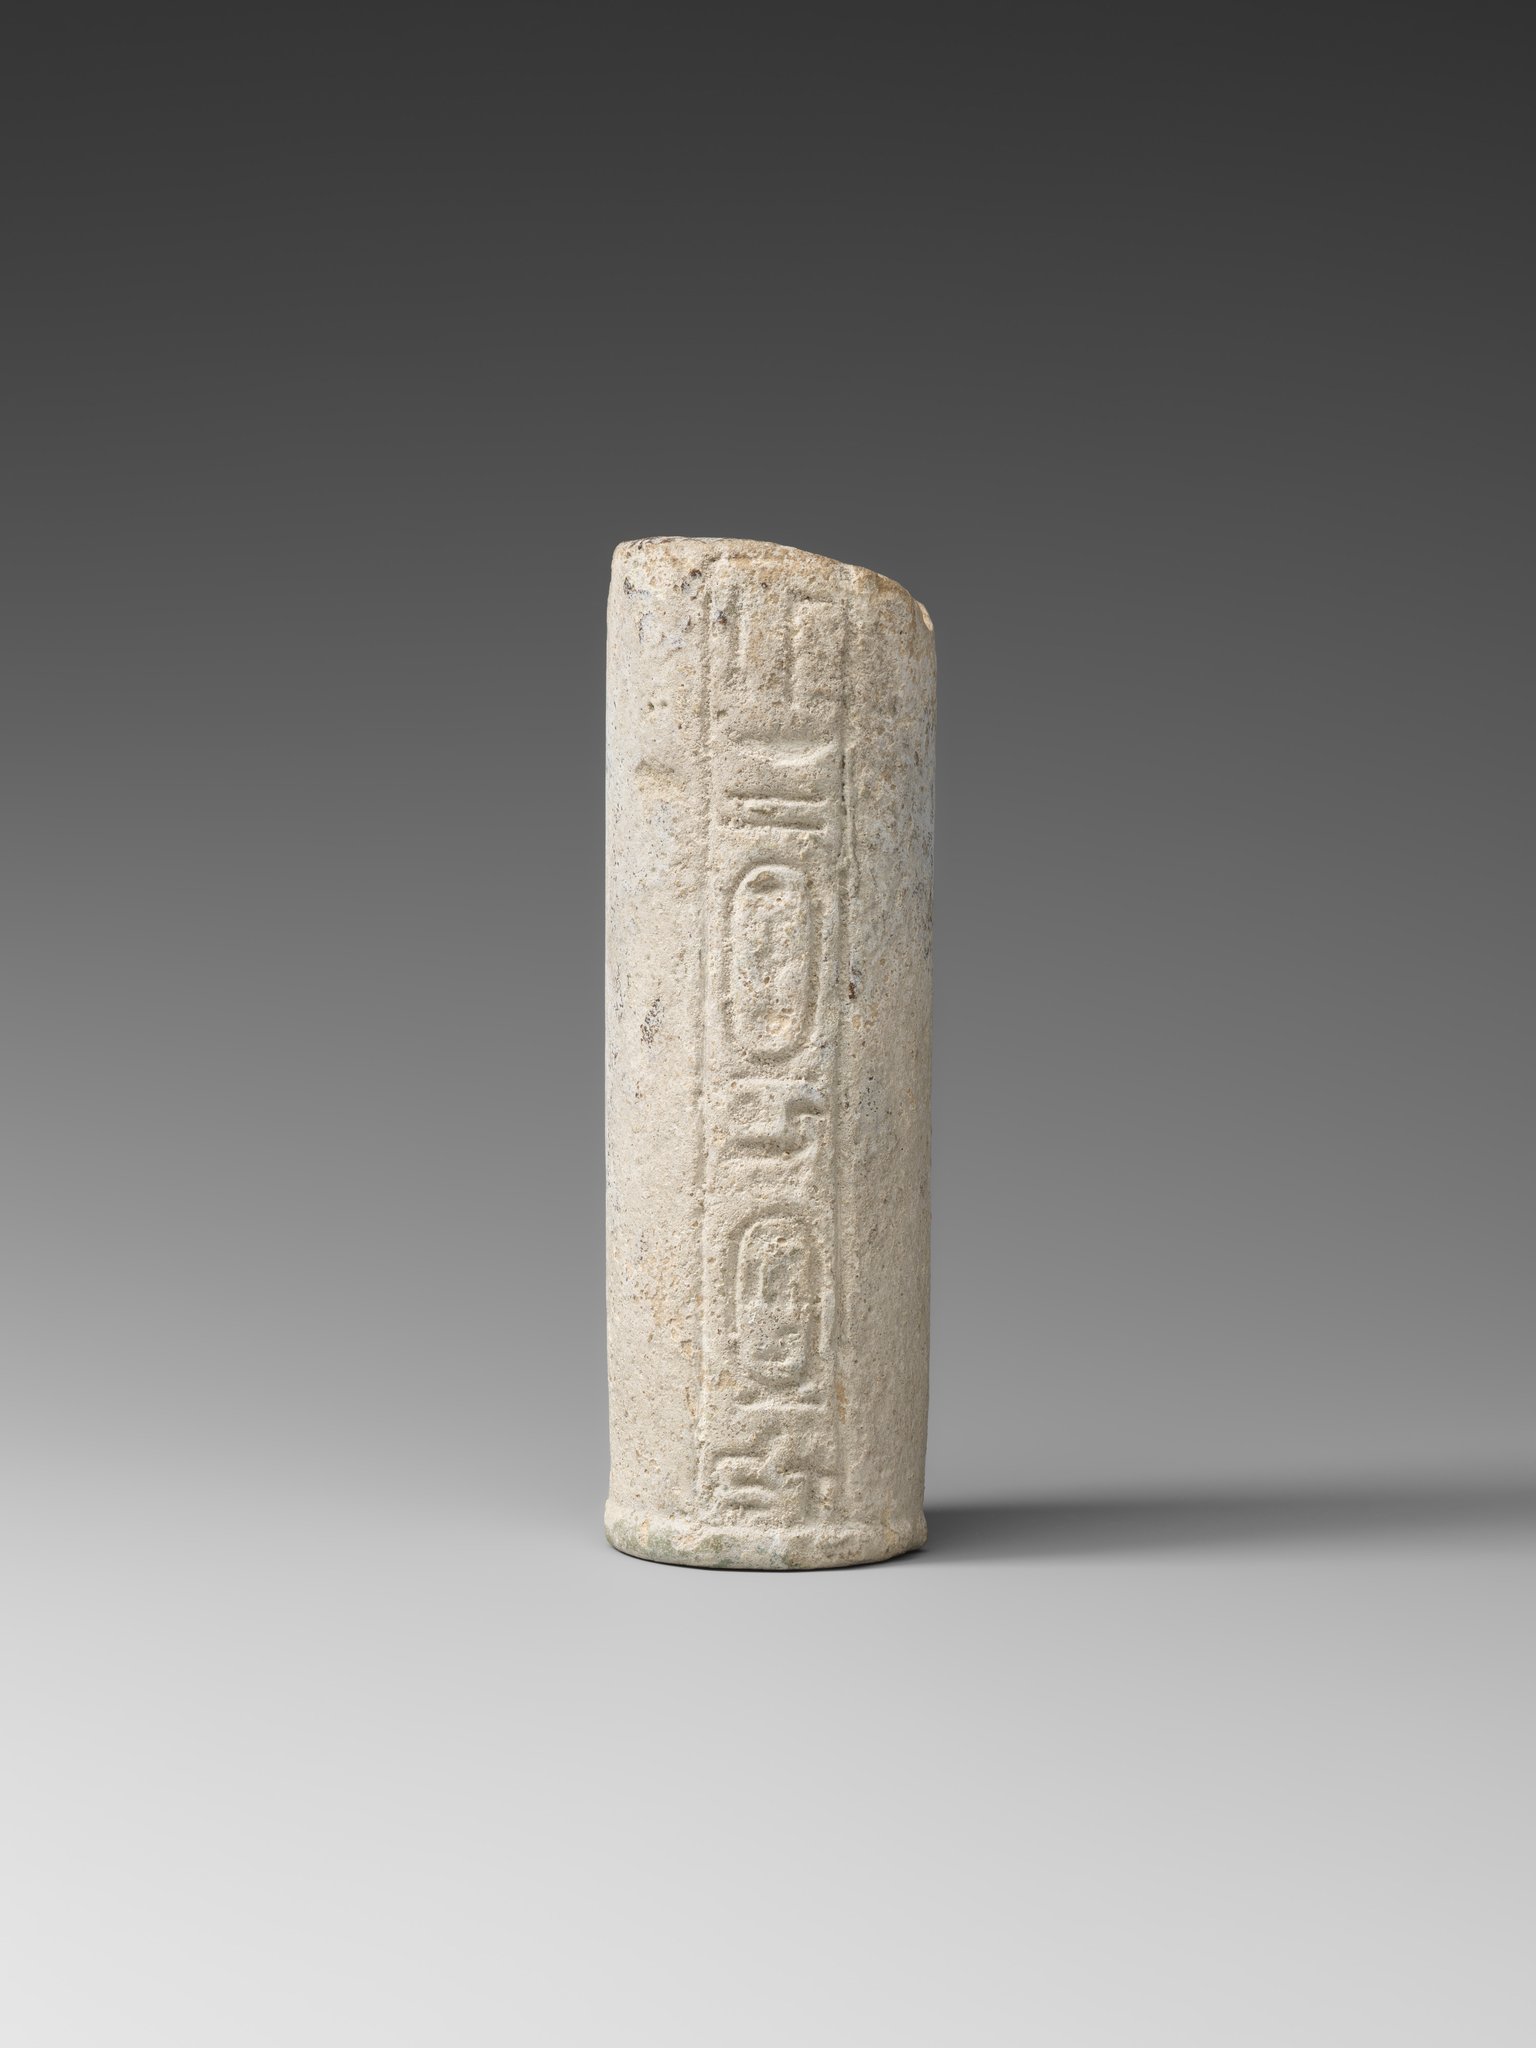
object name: music, sistrum, amasis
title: Fragment of Sistrum Handle with the name of Amasis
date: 570-526 BCE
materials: faience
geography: egypt